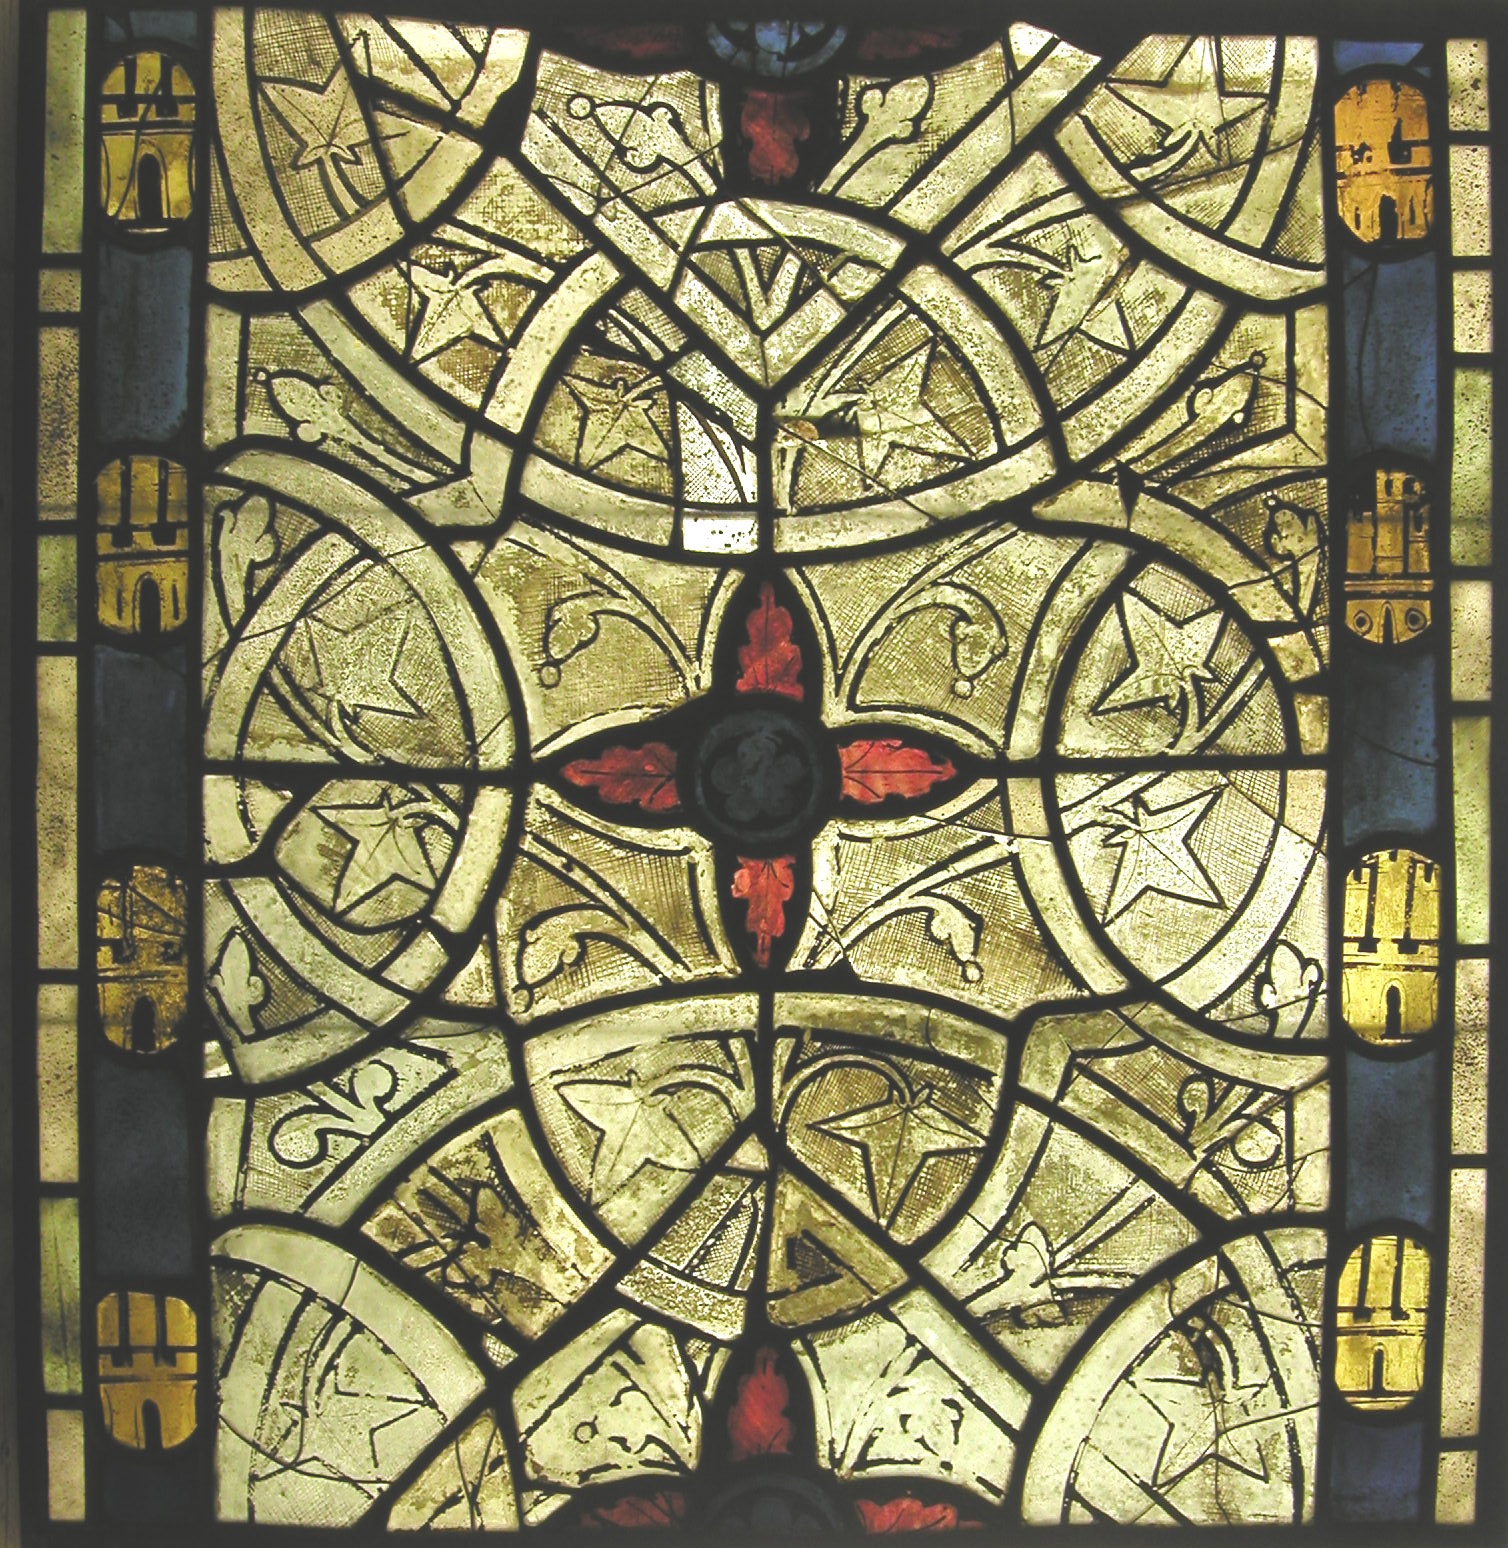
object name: panel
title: Grisaille Panel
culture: french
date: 1265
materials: glass, metal, paint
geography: france